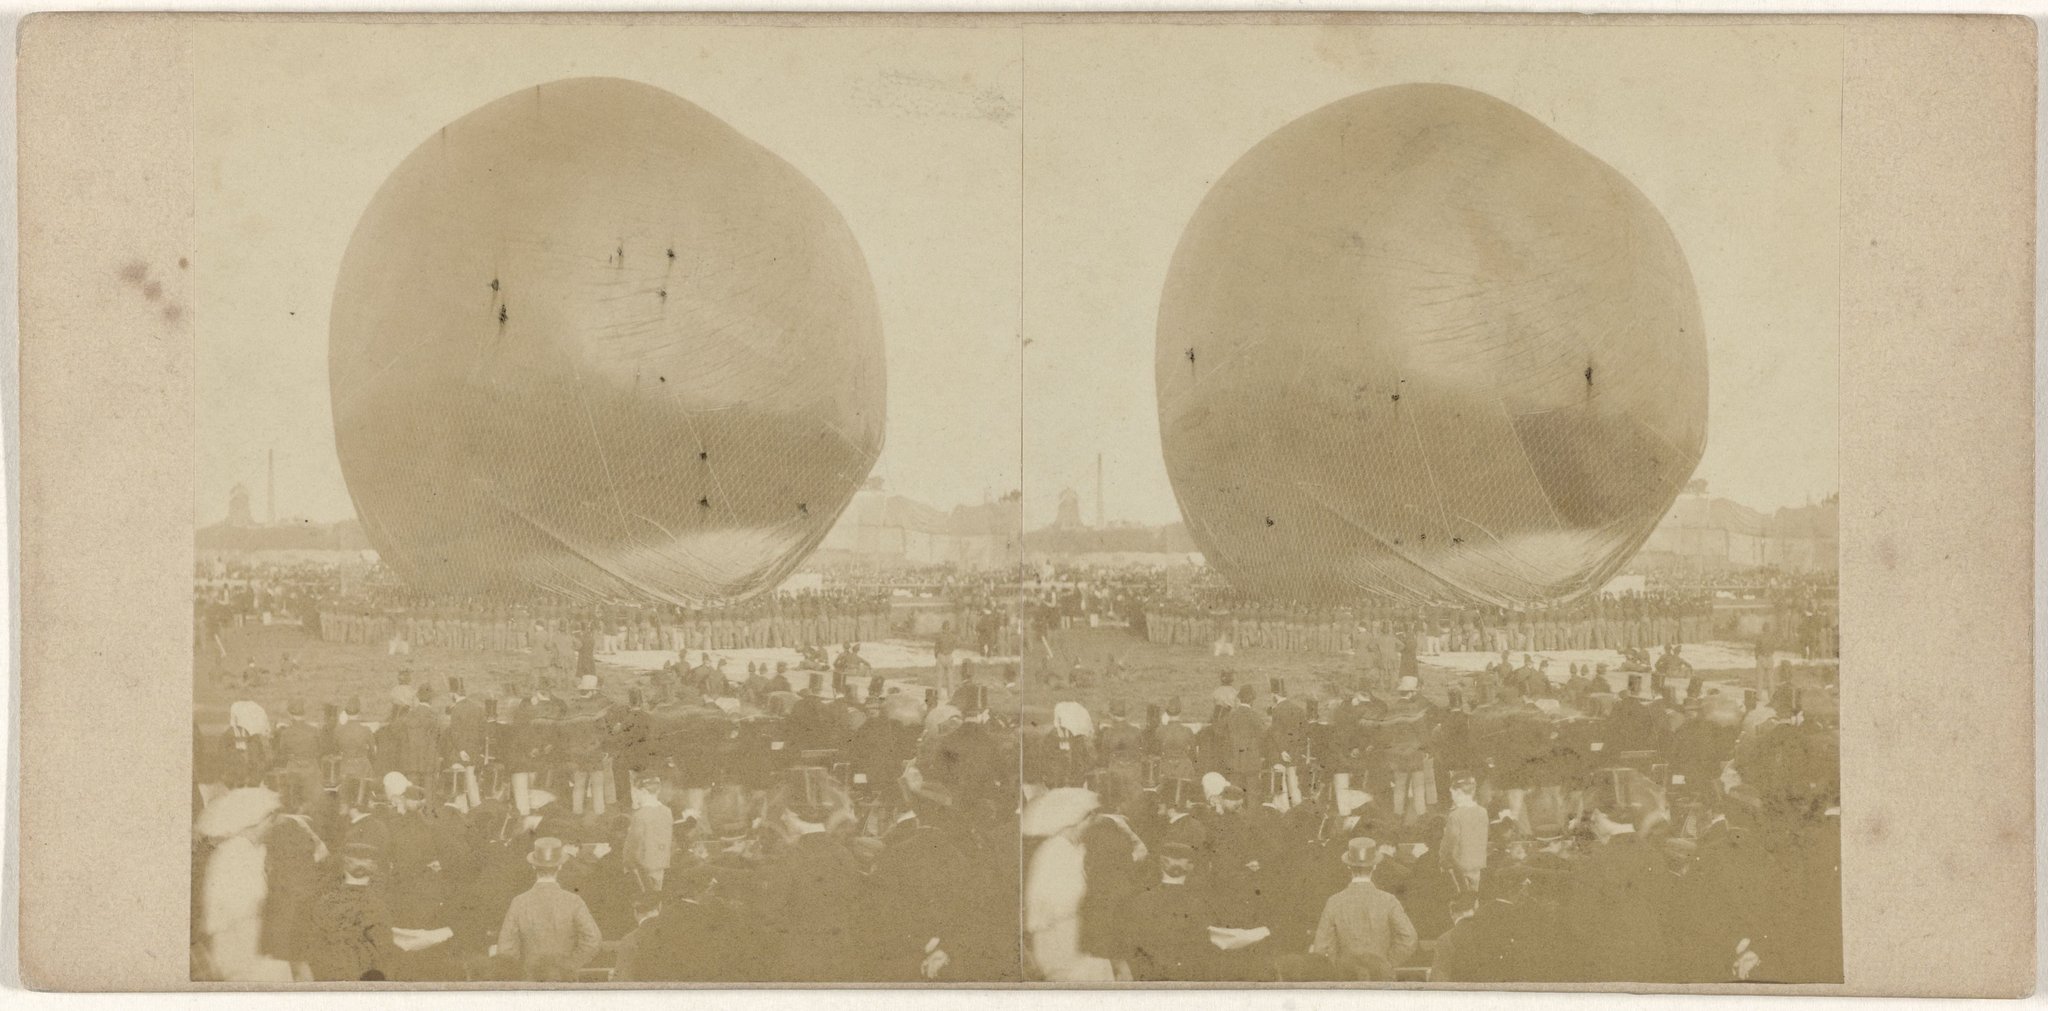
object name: stereograph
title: Reuzenballon 'le Géant' van Nadar wordt opgelaten in Amsterdam, 14 september 1865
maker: pieter oosterhuis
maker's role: draughtsman, print maker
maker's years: 1816-1885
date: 1865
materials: cardboard, paper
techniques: albumen print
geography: amsterdam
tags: balloon (aviation), amsterdam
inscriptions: number: ‘8’, retailer's mark: ‘BOEKHANDEL/ JAN D. BROUWER./ KALVERSTRAAT E N0 37/ AMSTERDAM.’